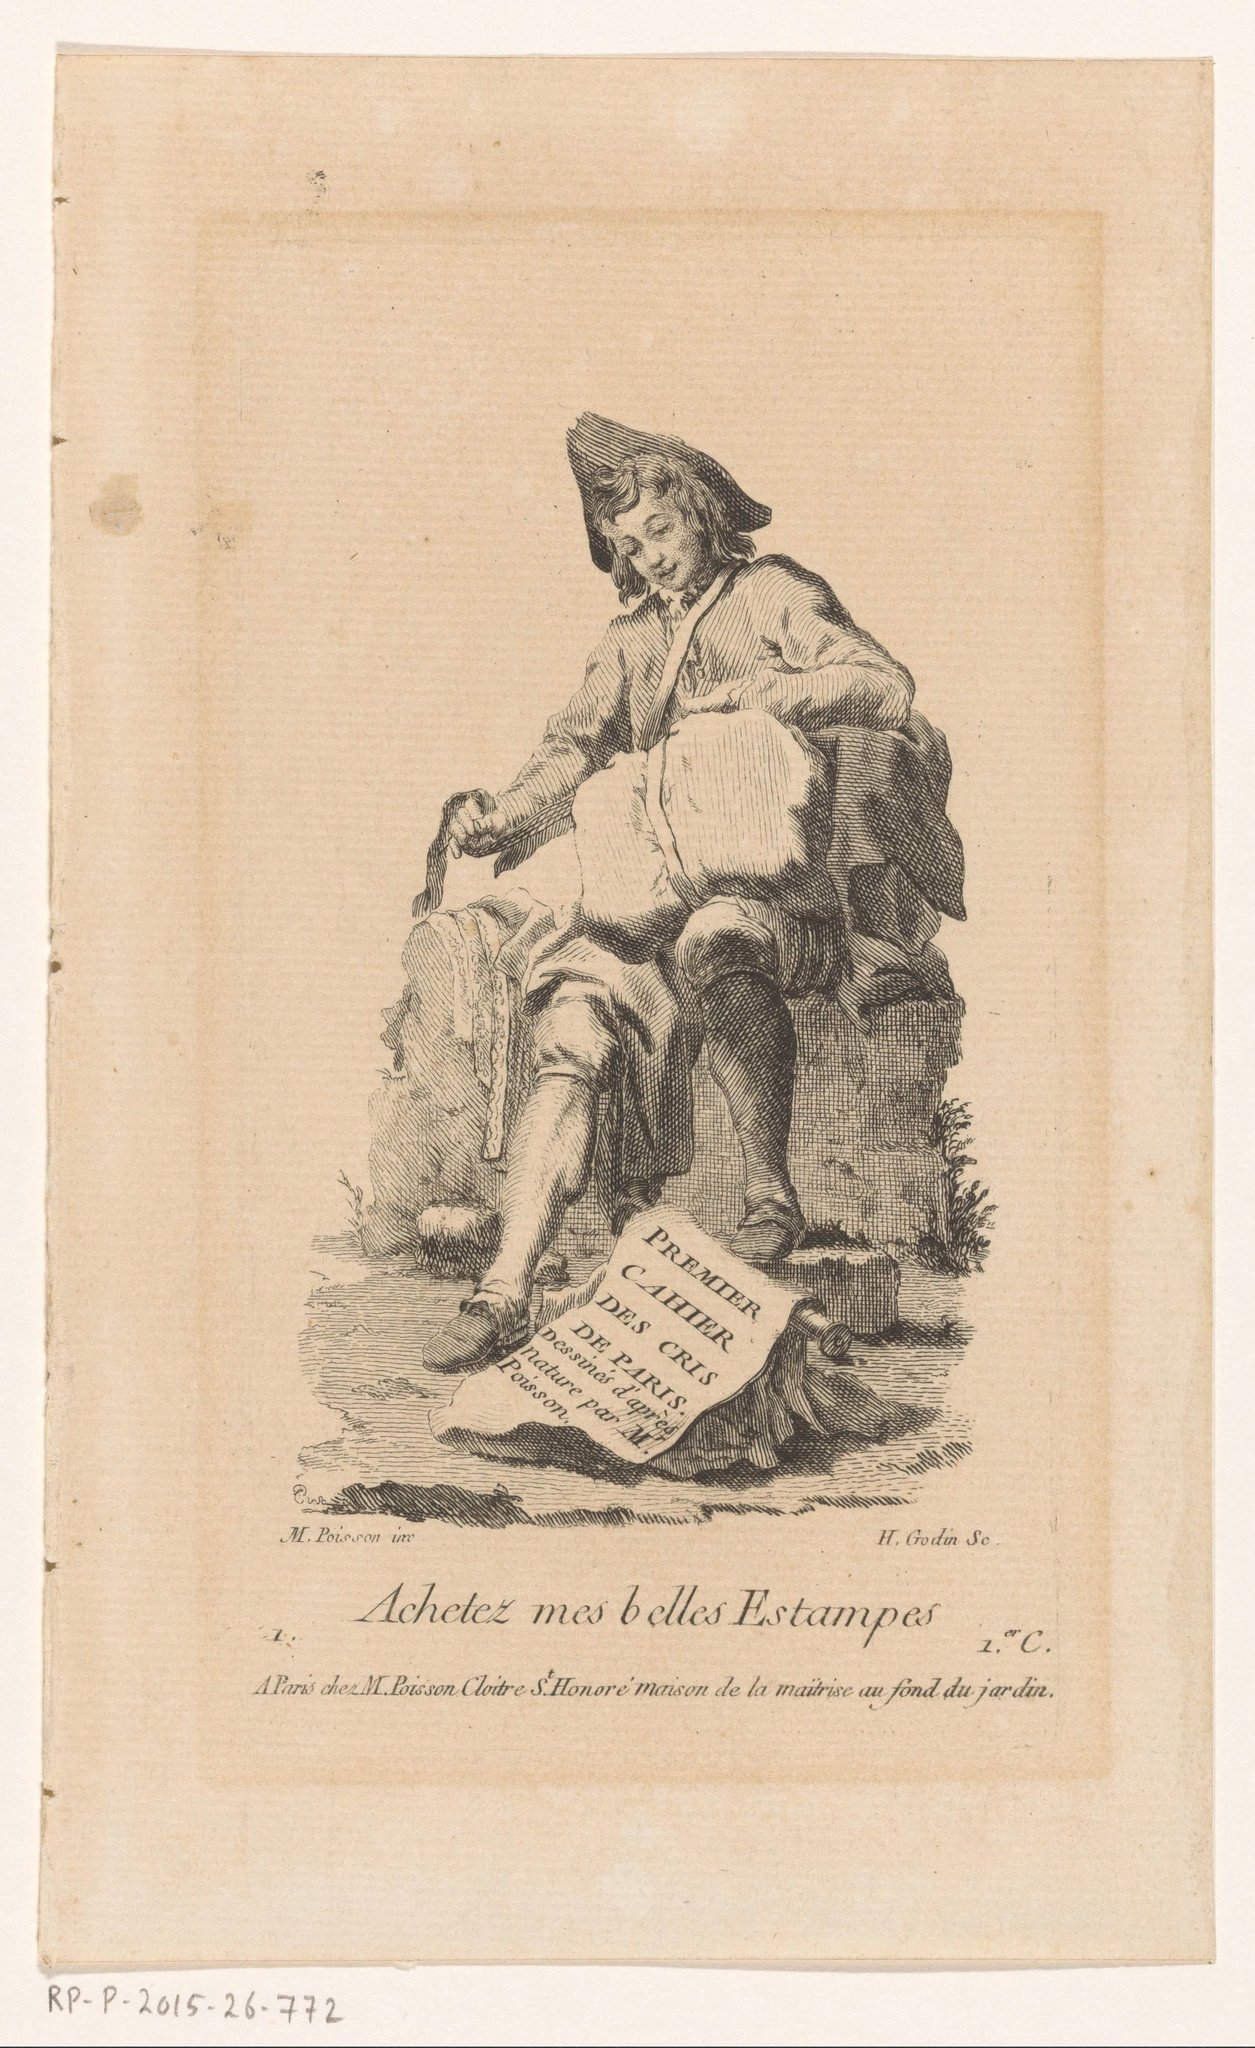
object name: print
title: Straatverkopers van Parijs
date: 1774-1775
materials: paper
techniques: etching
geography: paris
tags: print, e.g.: engraving, etching, lithograph, 'cris de paris', cries of london, etc.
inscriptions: collector's mark: Lugt 2228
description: Titelprent van het eerste deel van de serie Cris de Paris, bestaande uit 72 prenten, uitgegeven in 12 delen, voor het eerst uitgegeven tussen 1774-1775.